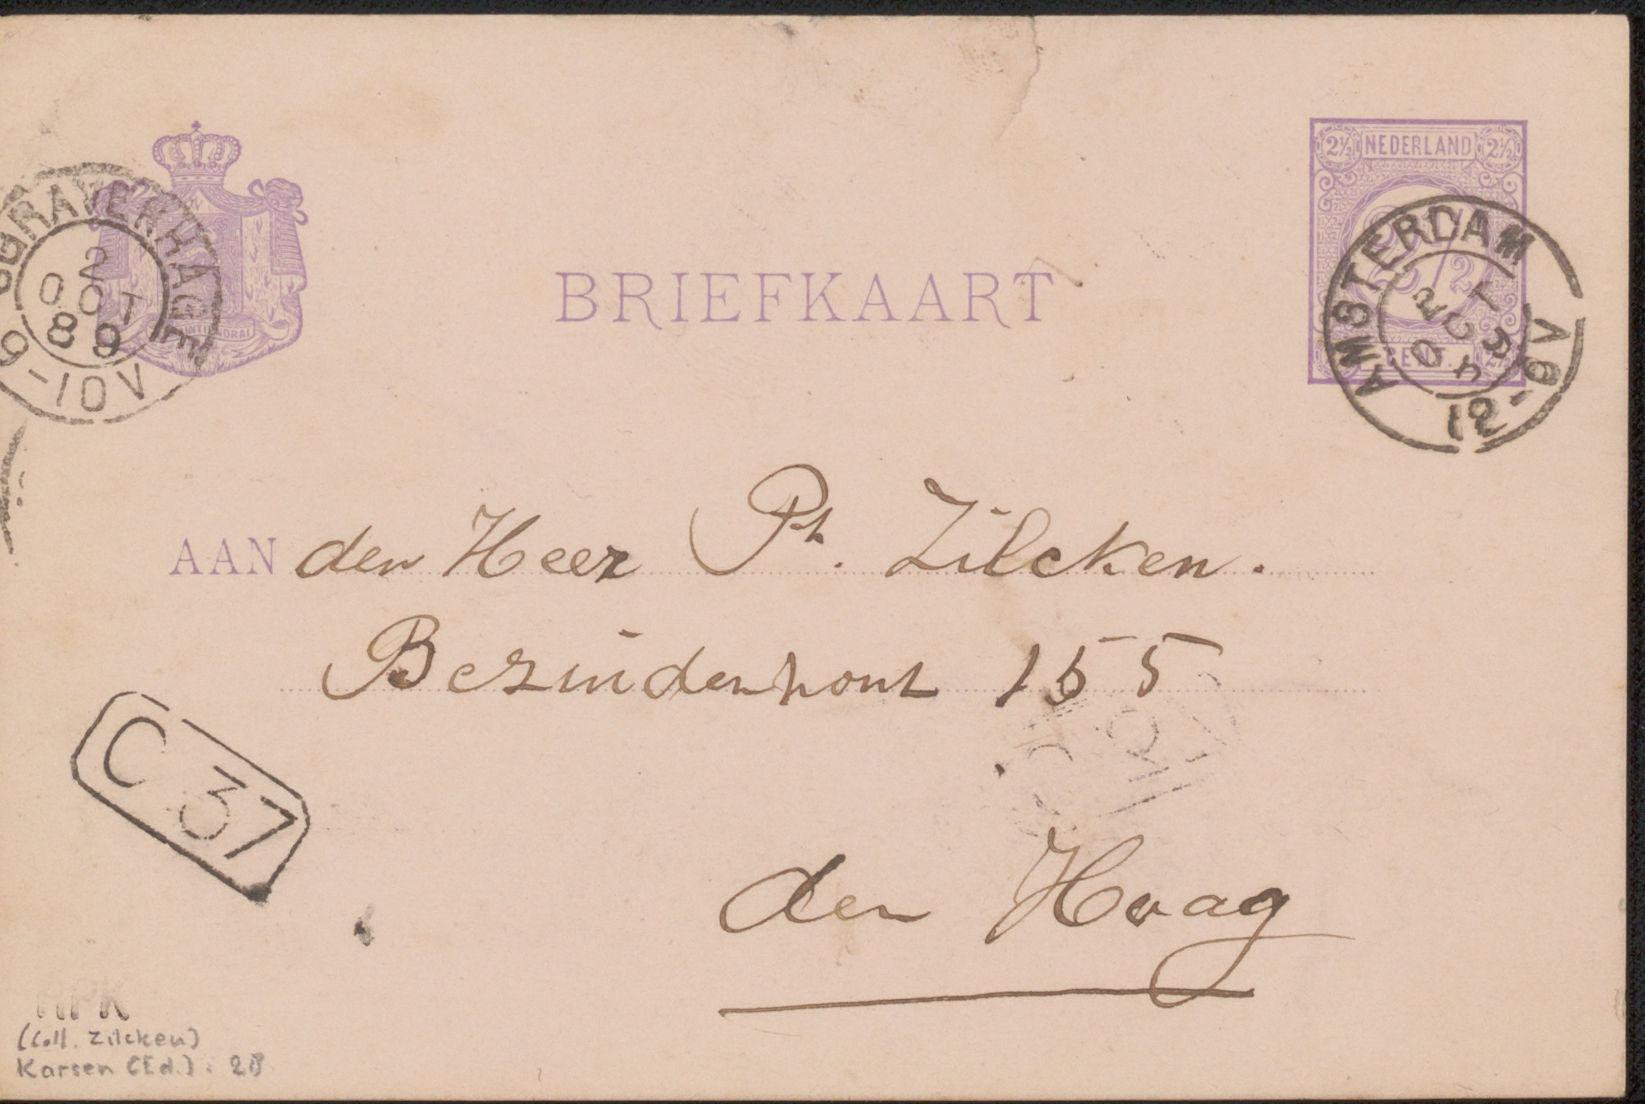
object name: postcard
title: Briefkaart aan Philip Zilcken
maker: eduard karsen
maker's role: draughtsman, painter, print maker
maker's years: 1860-1941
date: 1889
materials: cardboard, ink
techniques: pen, writing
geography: amsterdam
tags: the hague, painter, draughtsman, philip zilcken, money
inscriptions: collector's mark: ‘RPK’